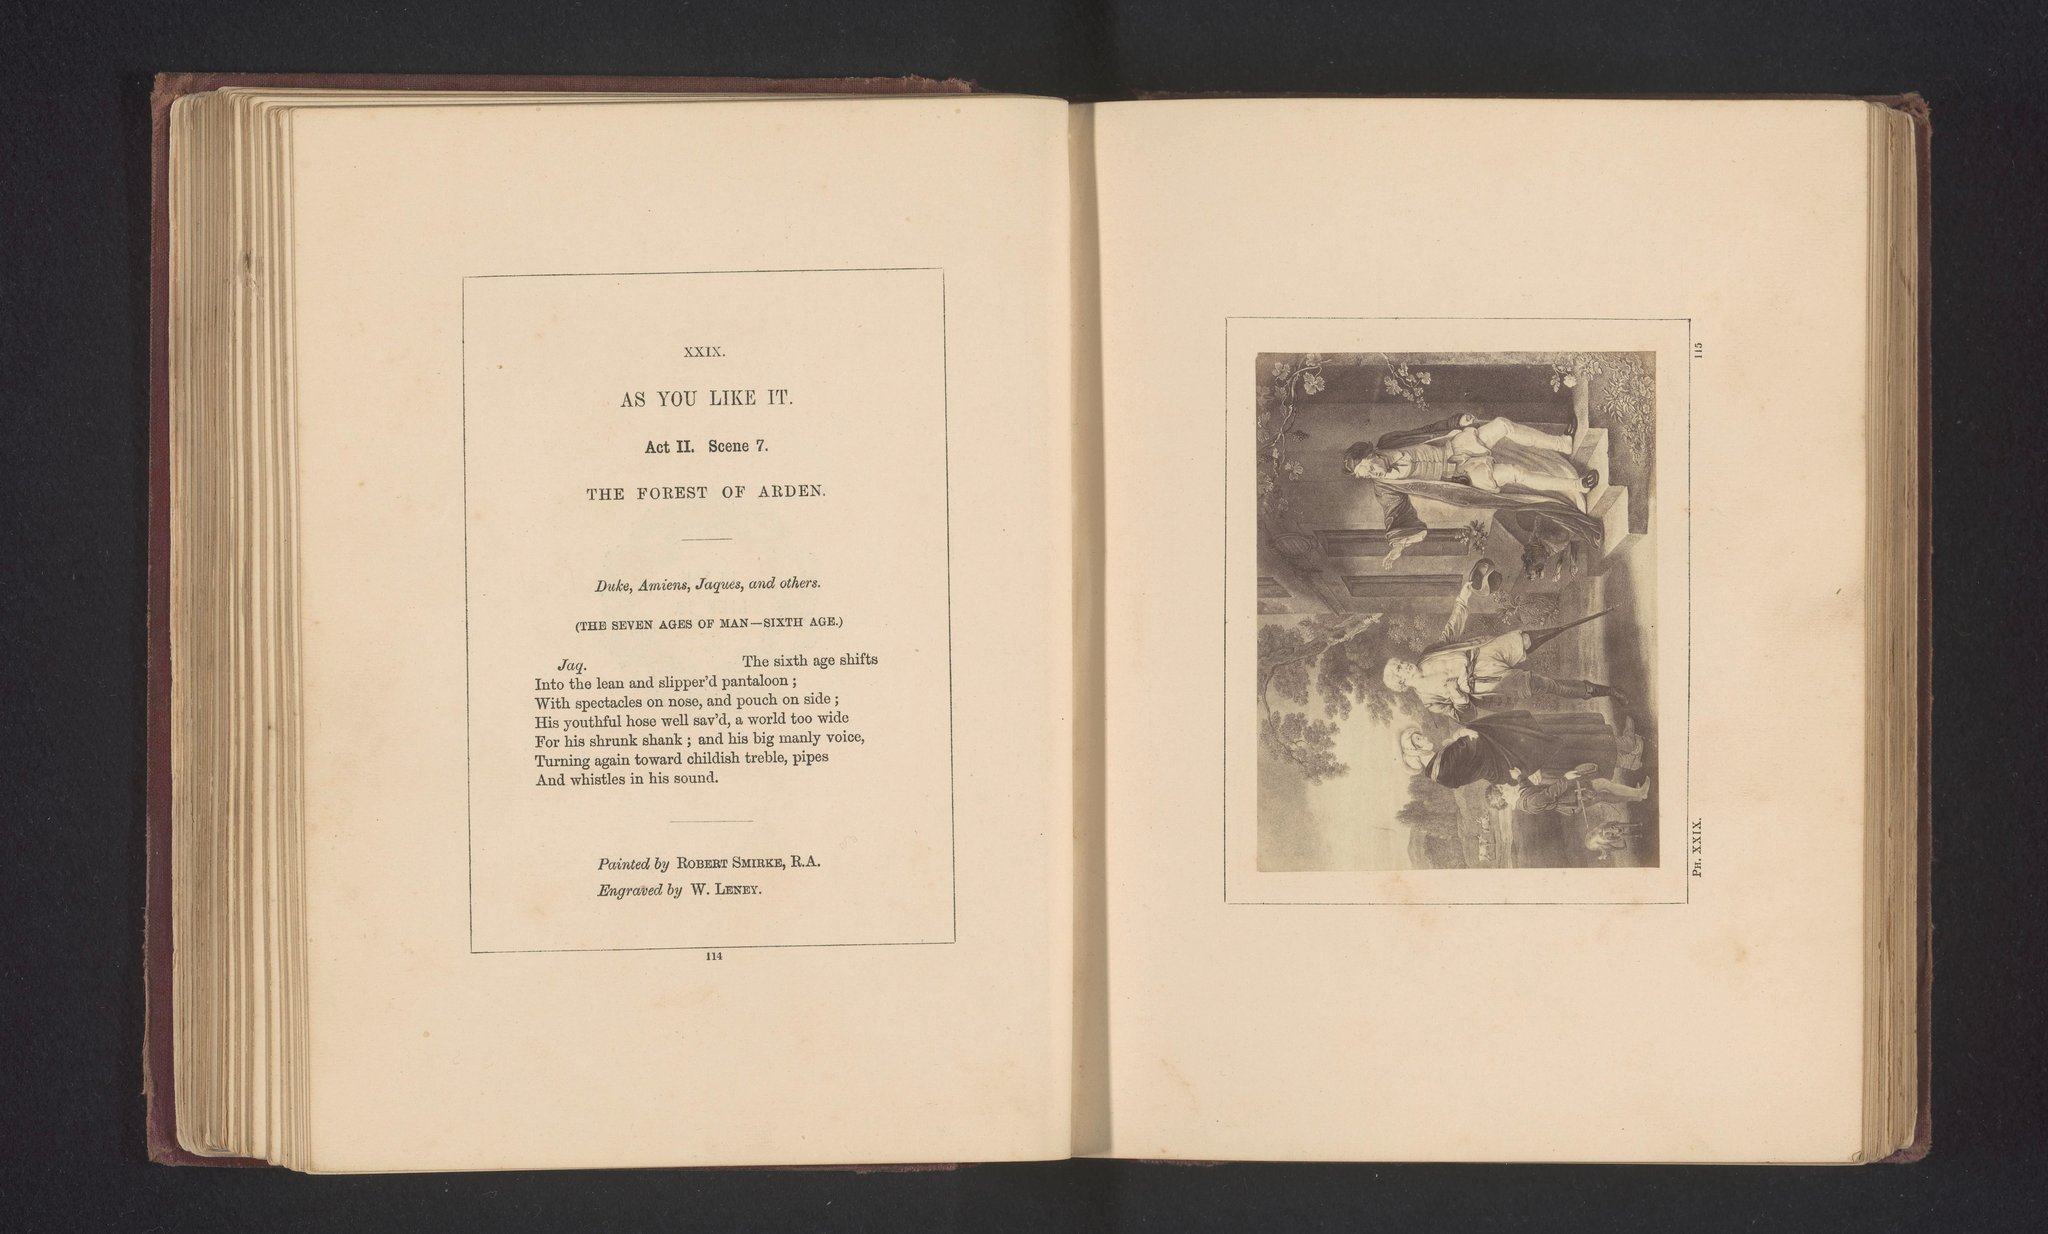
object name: photograph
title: Fotoreproductie van een prent naar een schilderij door Robert Smirke, voorstellend een scene uit Naar het u bevalt door William Shakespeare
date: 1854-1867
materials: photographic support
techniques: albumen print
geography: london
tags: specific works of literature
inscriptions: number: ‘Ph. XXIX. 115’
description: Te zien is een verbeelding van akte II, scene 7; Seven Ages Of Man.